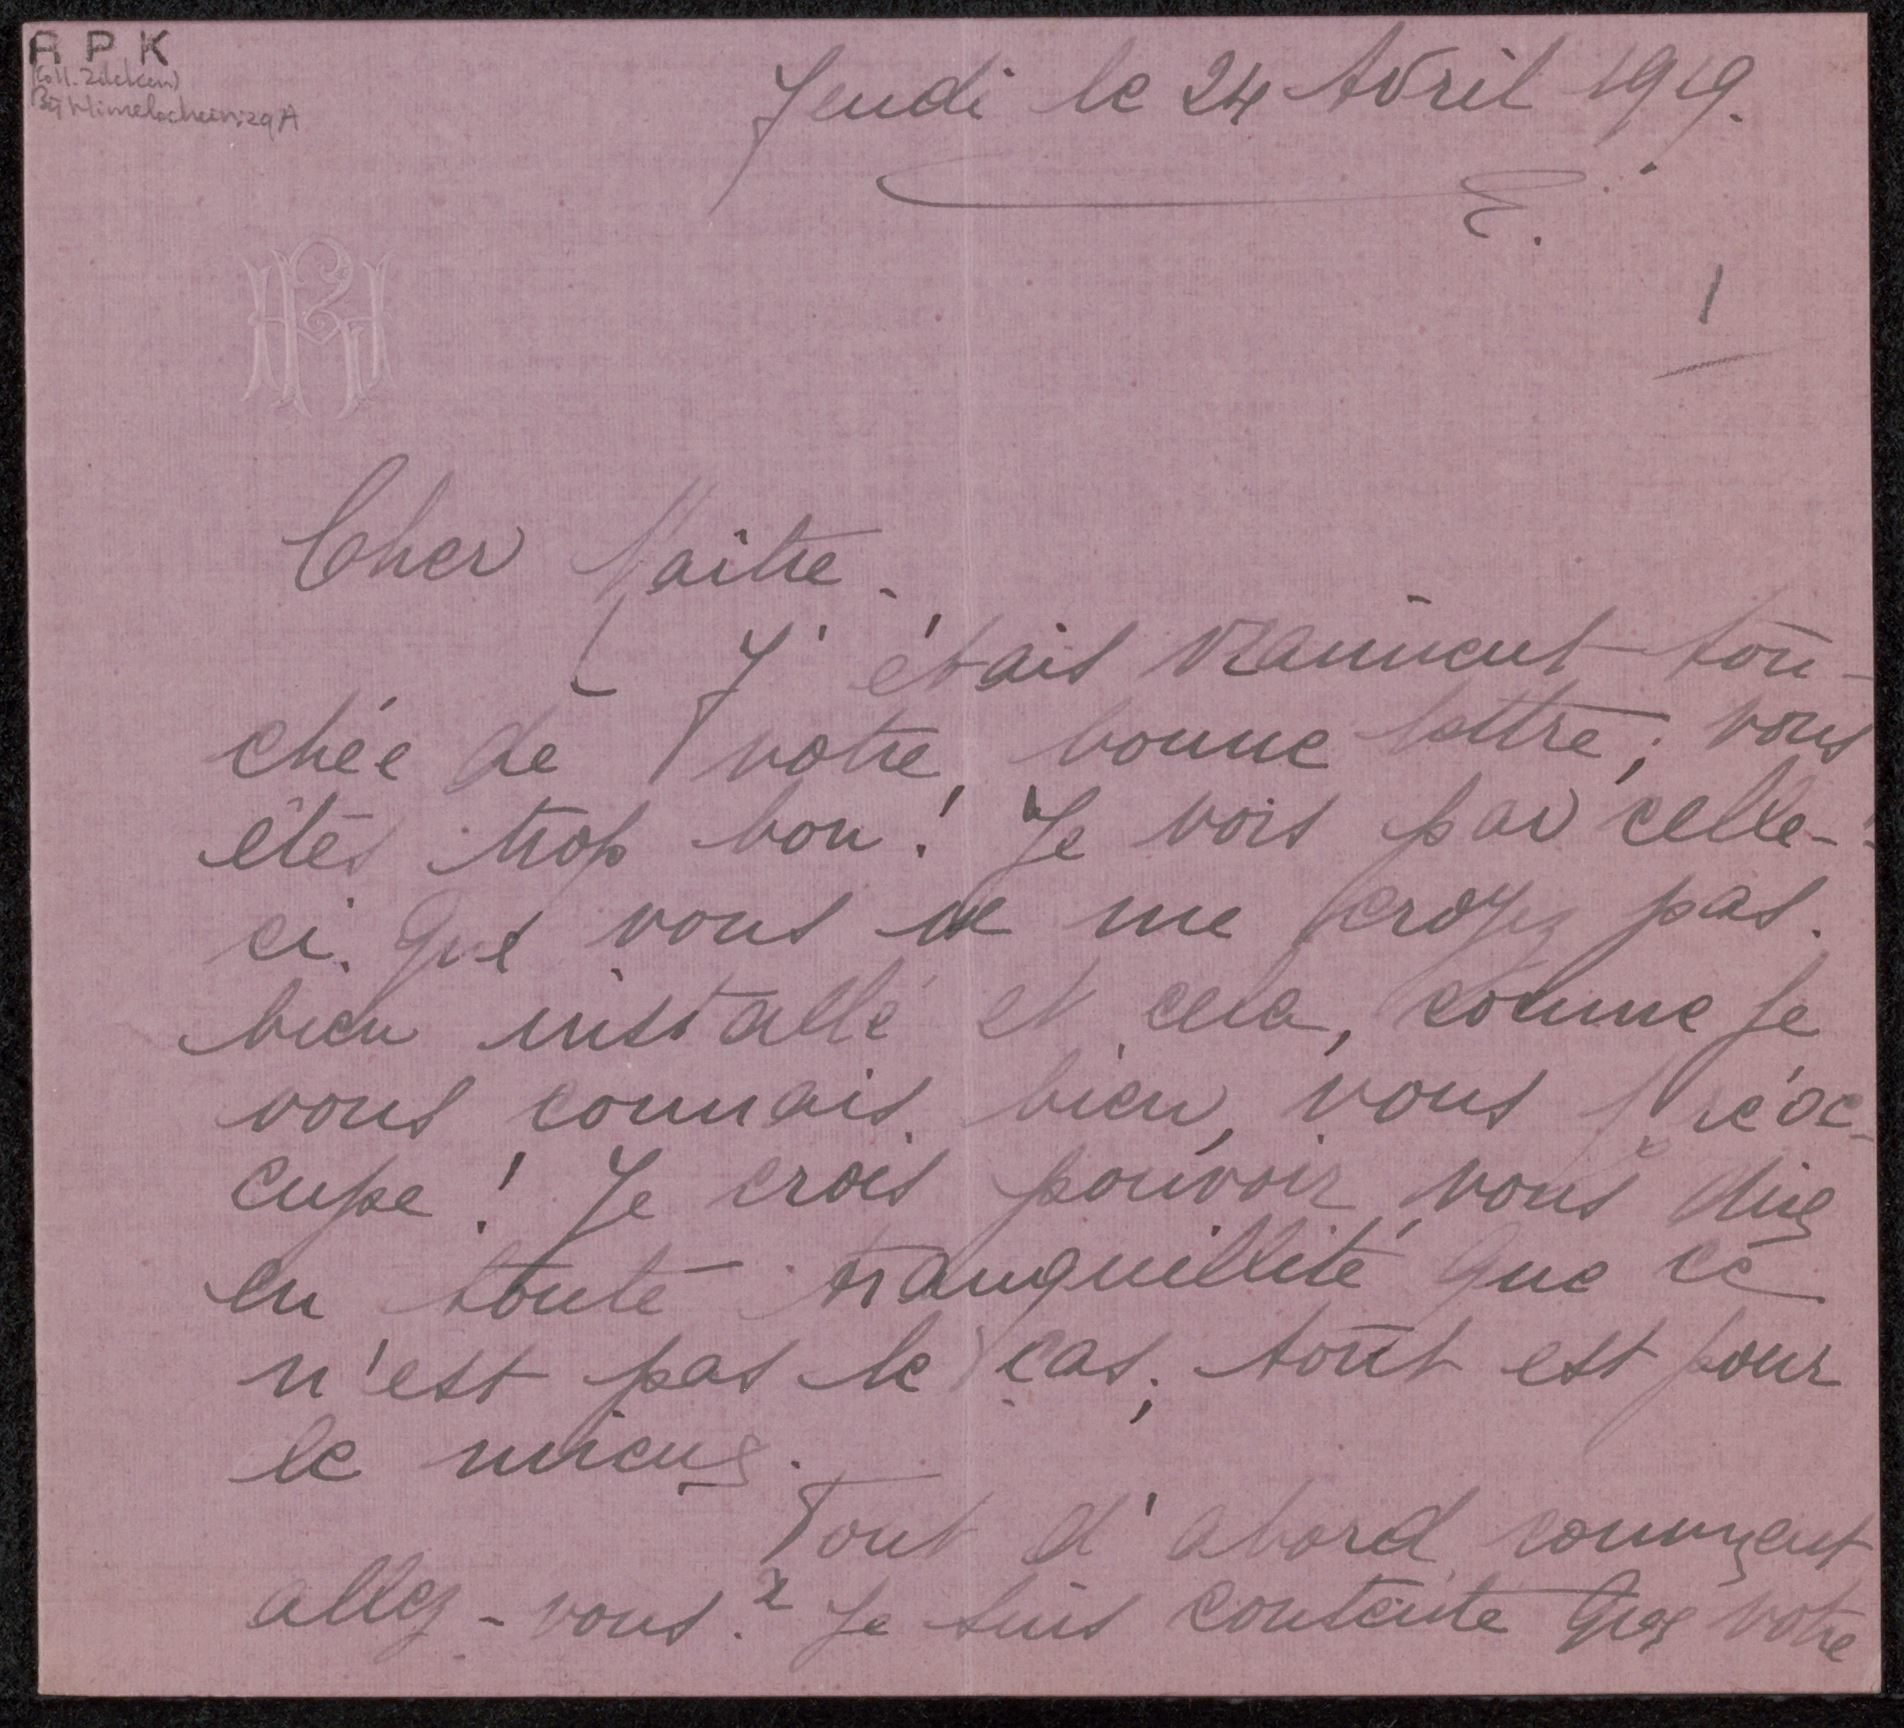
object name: letter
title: Brief aan Philip Zilcken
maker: rose imel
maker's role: draughtsman, painter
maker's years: 1901-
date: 1919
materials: ink, paper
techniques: pen, writing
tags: painter, draughtsman, philip zilcken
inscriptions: monogram: ‘RH’, collector's mark: ‘RPK’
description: RP-D-1982-43-HIMELSCHEIN-29A vormt samen met RP-D-1982-43-HIMELSCHEIN-29B en RP-D-1982-43-HIMELSCHEIN-29C een doorlopende brief.